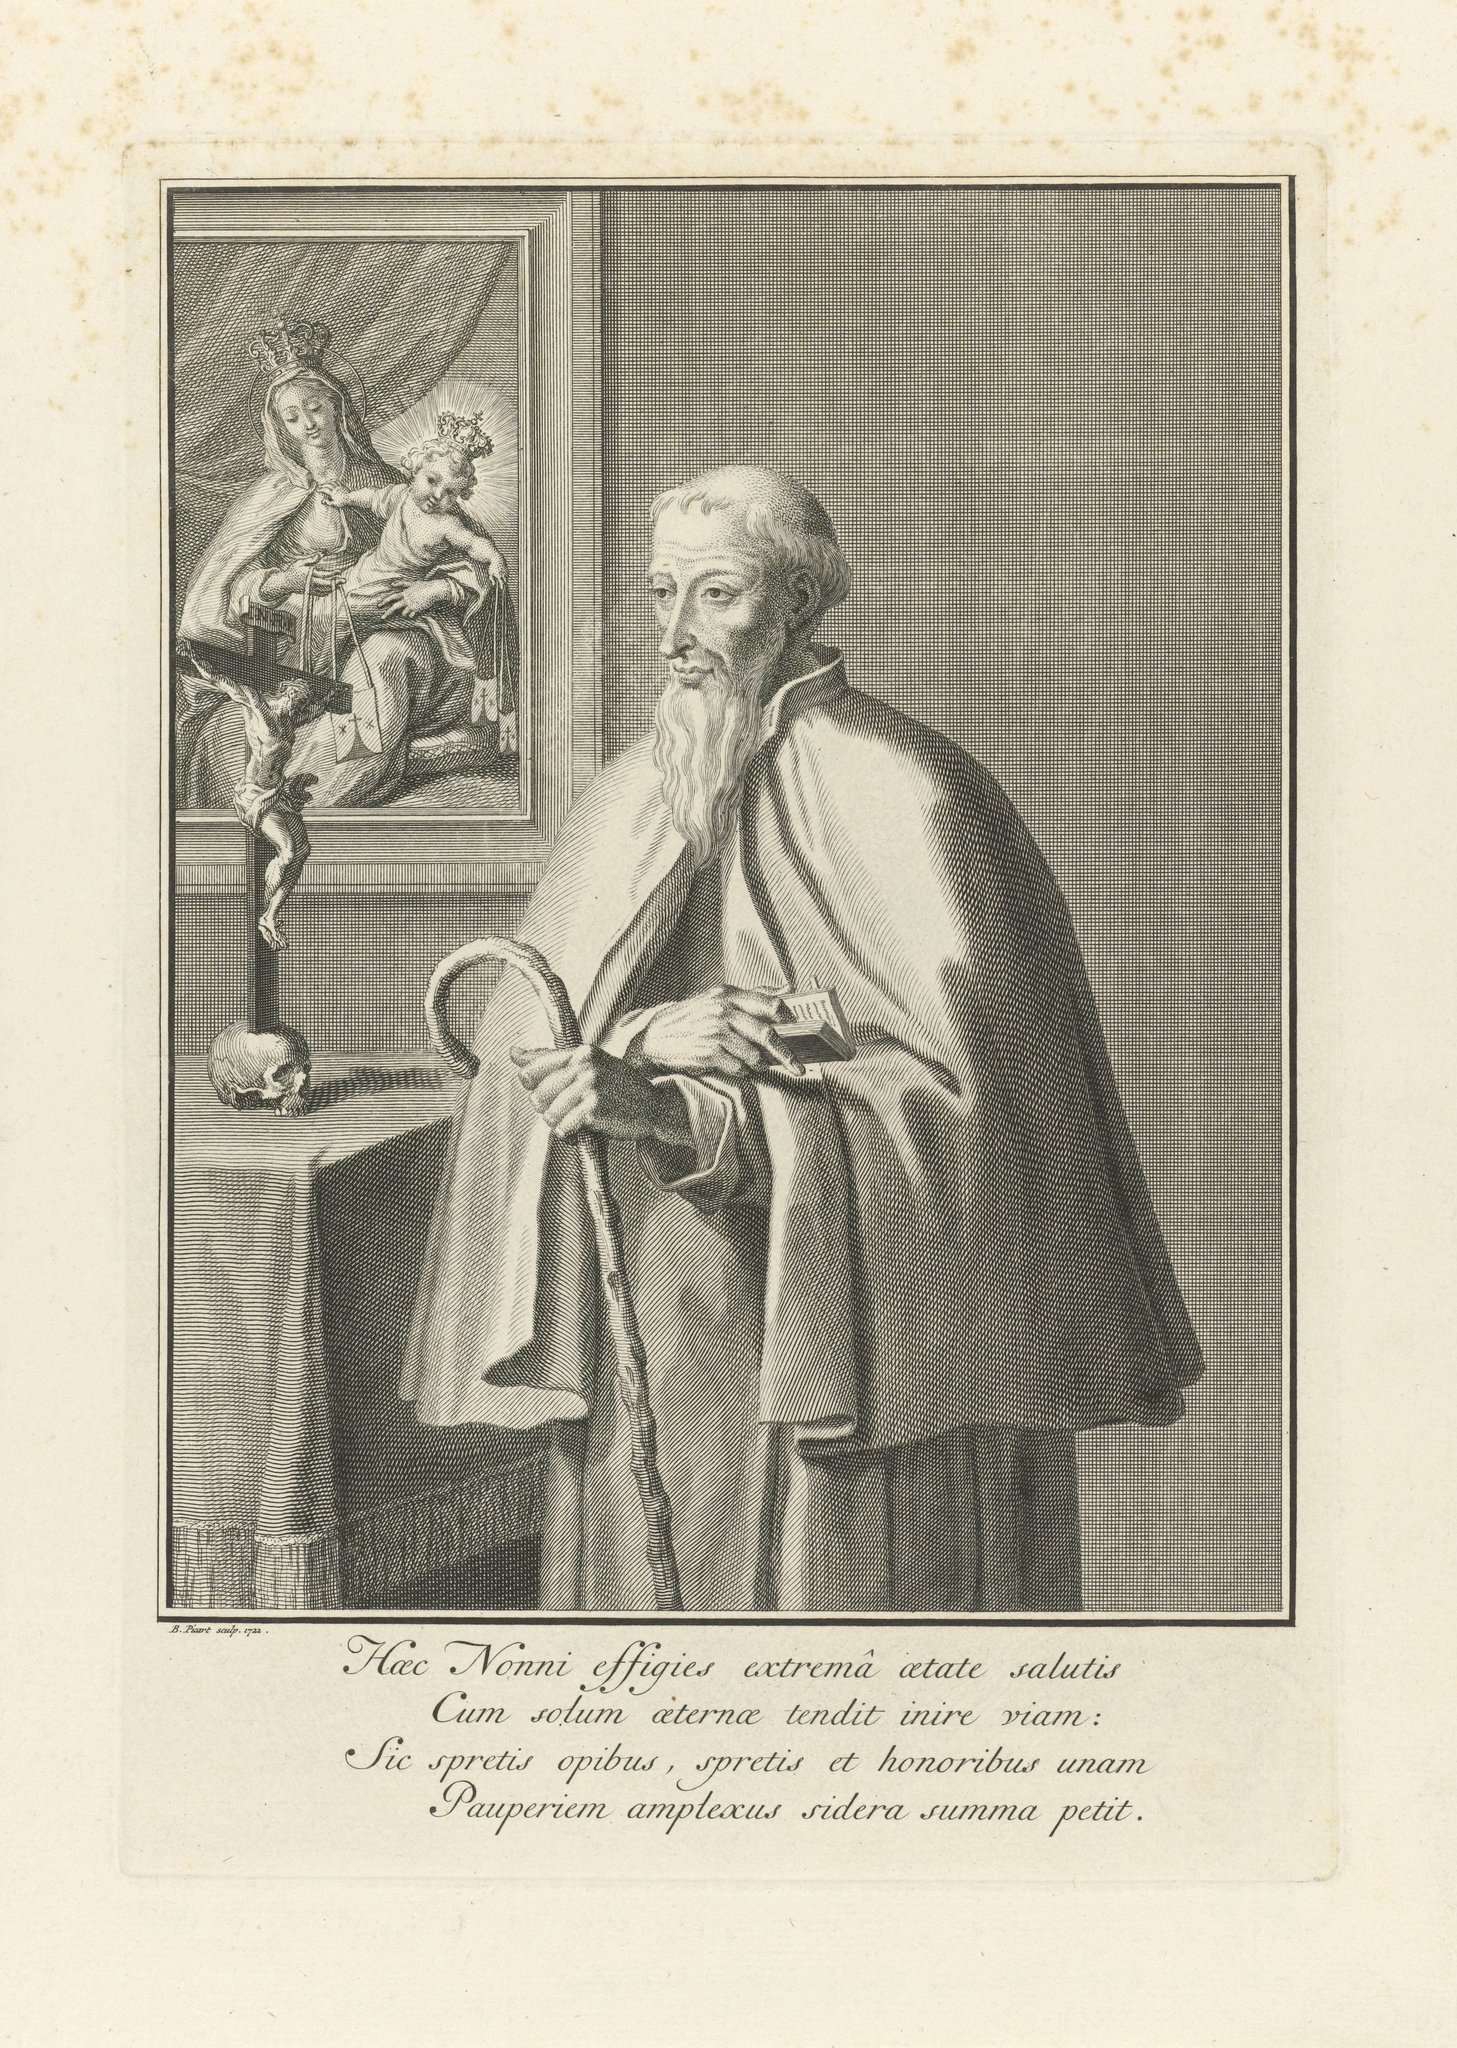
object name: print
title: Portret van Nuno Álvares Pereira, in habijt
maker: bernard picart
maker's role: draughtsman, print maker, publisher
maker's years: 1673-1733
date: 1722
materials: paper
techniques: engraving, etching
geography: amsterdam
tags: madonna: i.e. mary with the christ-child, monk(s), friar(s), crucifix ~ personal devotion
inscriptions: collector's mark: Lugt 240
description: Portret van Nuno Álvares Pereira, in gebed voor een crucifix. Aan de muur hangt een schilderij van Maria met het Christuskind. In de marge een vierregelig onderschrift in het Latijn.